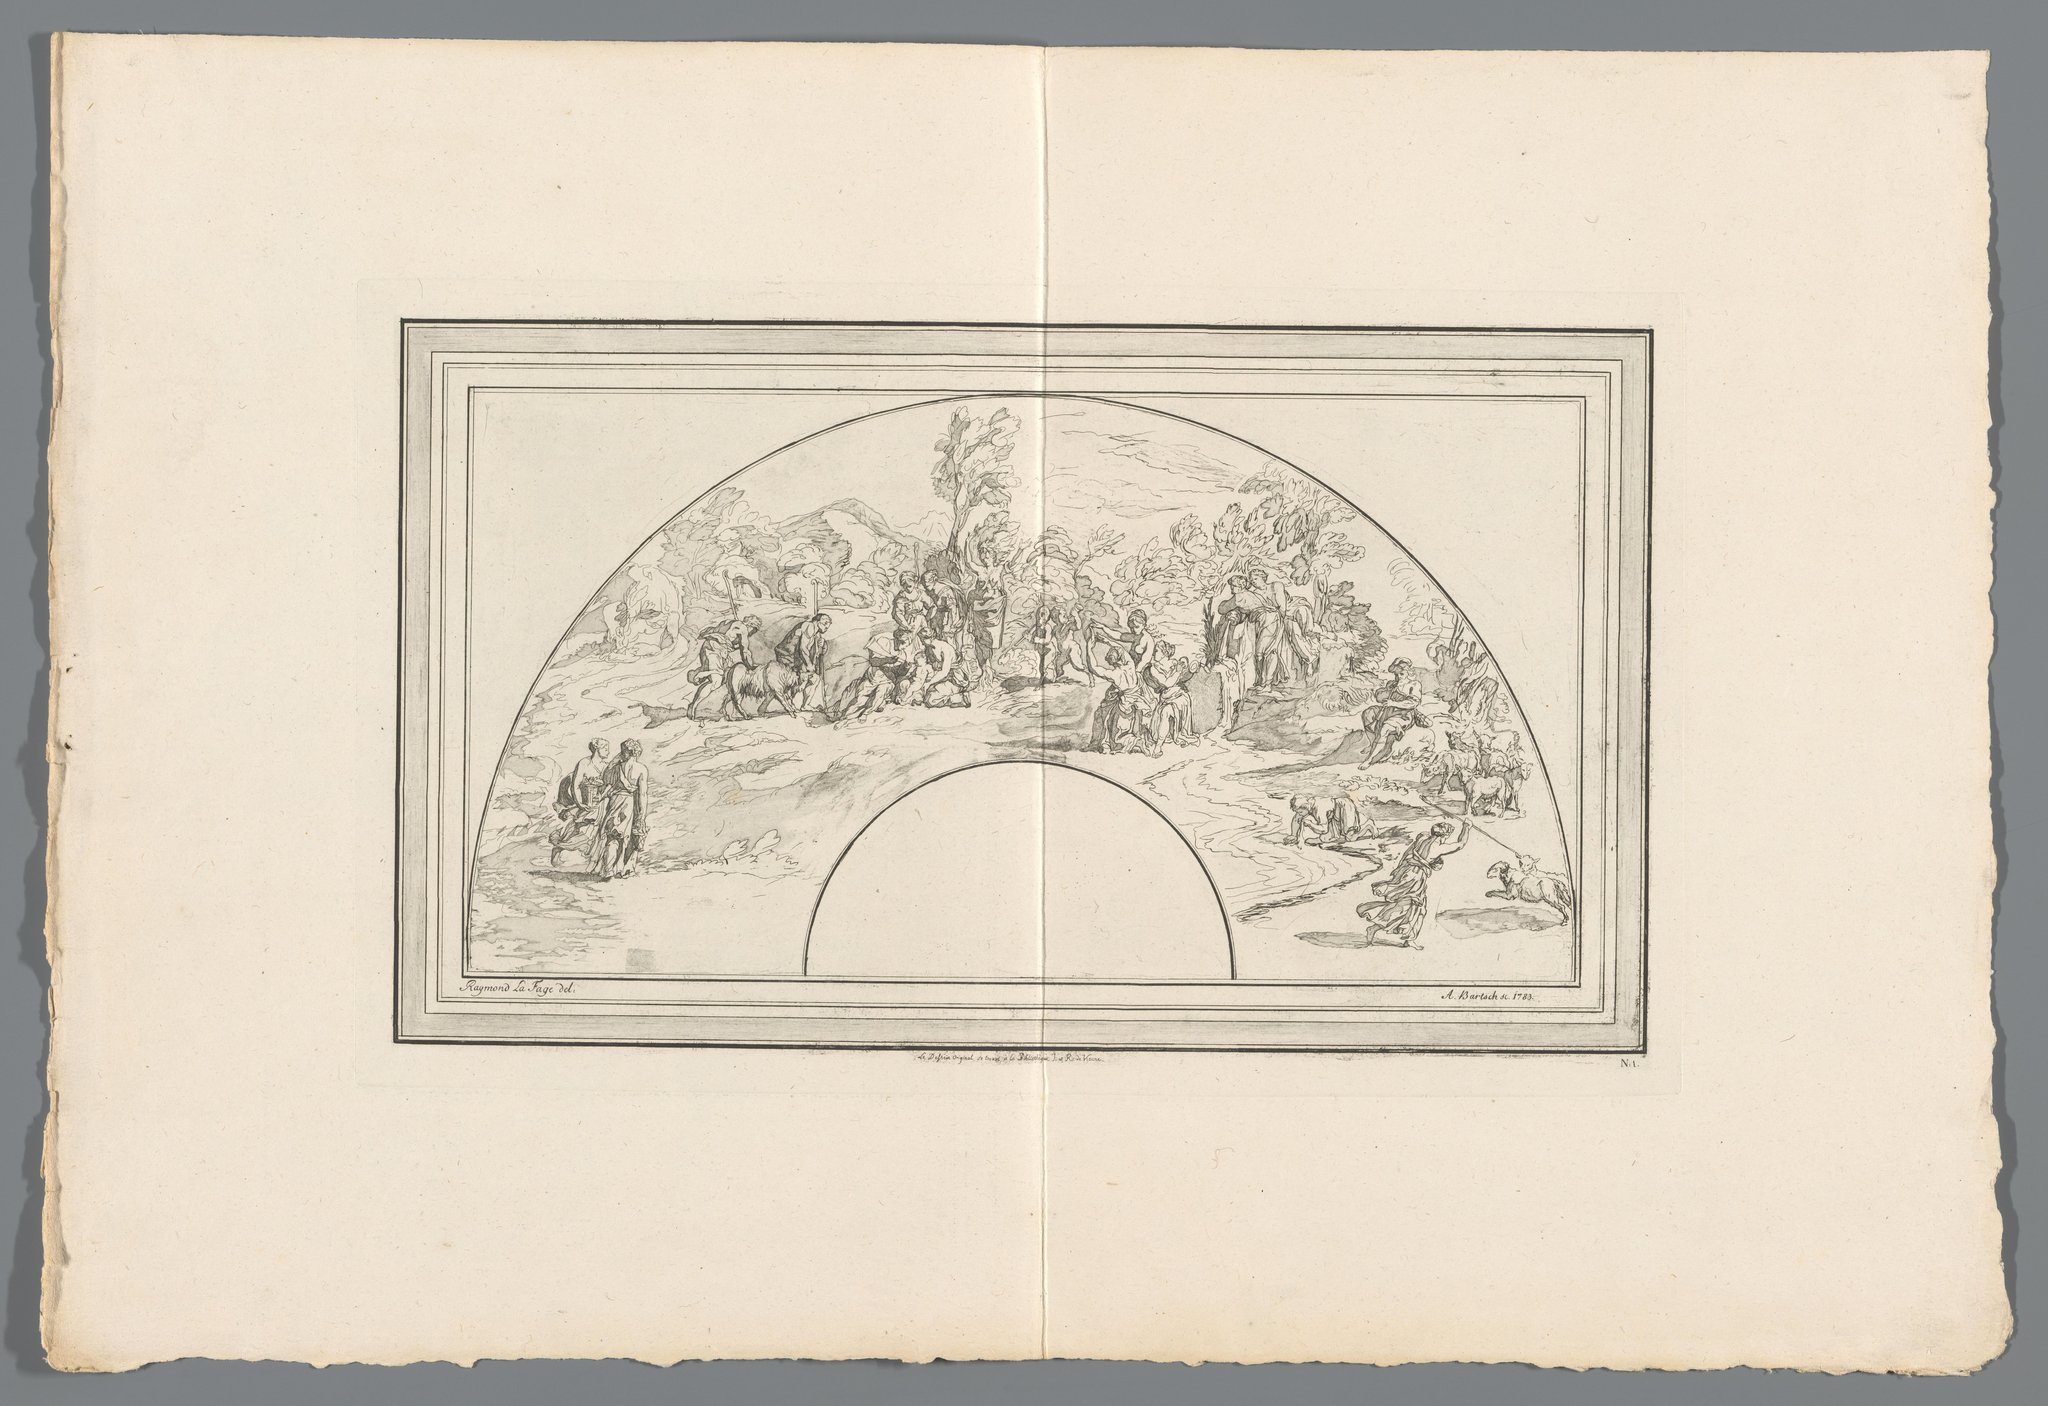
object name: print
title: Geboorte van Adonis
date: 1783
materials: paper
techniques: aquatint, etching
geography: vienna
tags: birth of adonis: the tree splits open to release the baby; the naiads take care of him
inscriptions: collector's mark: Lugt 2228